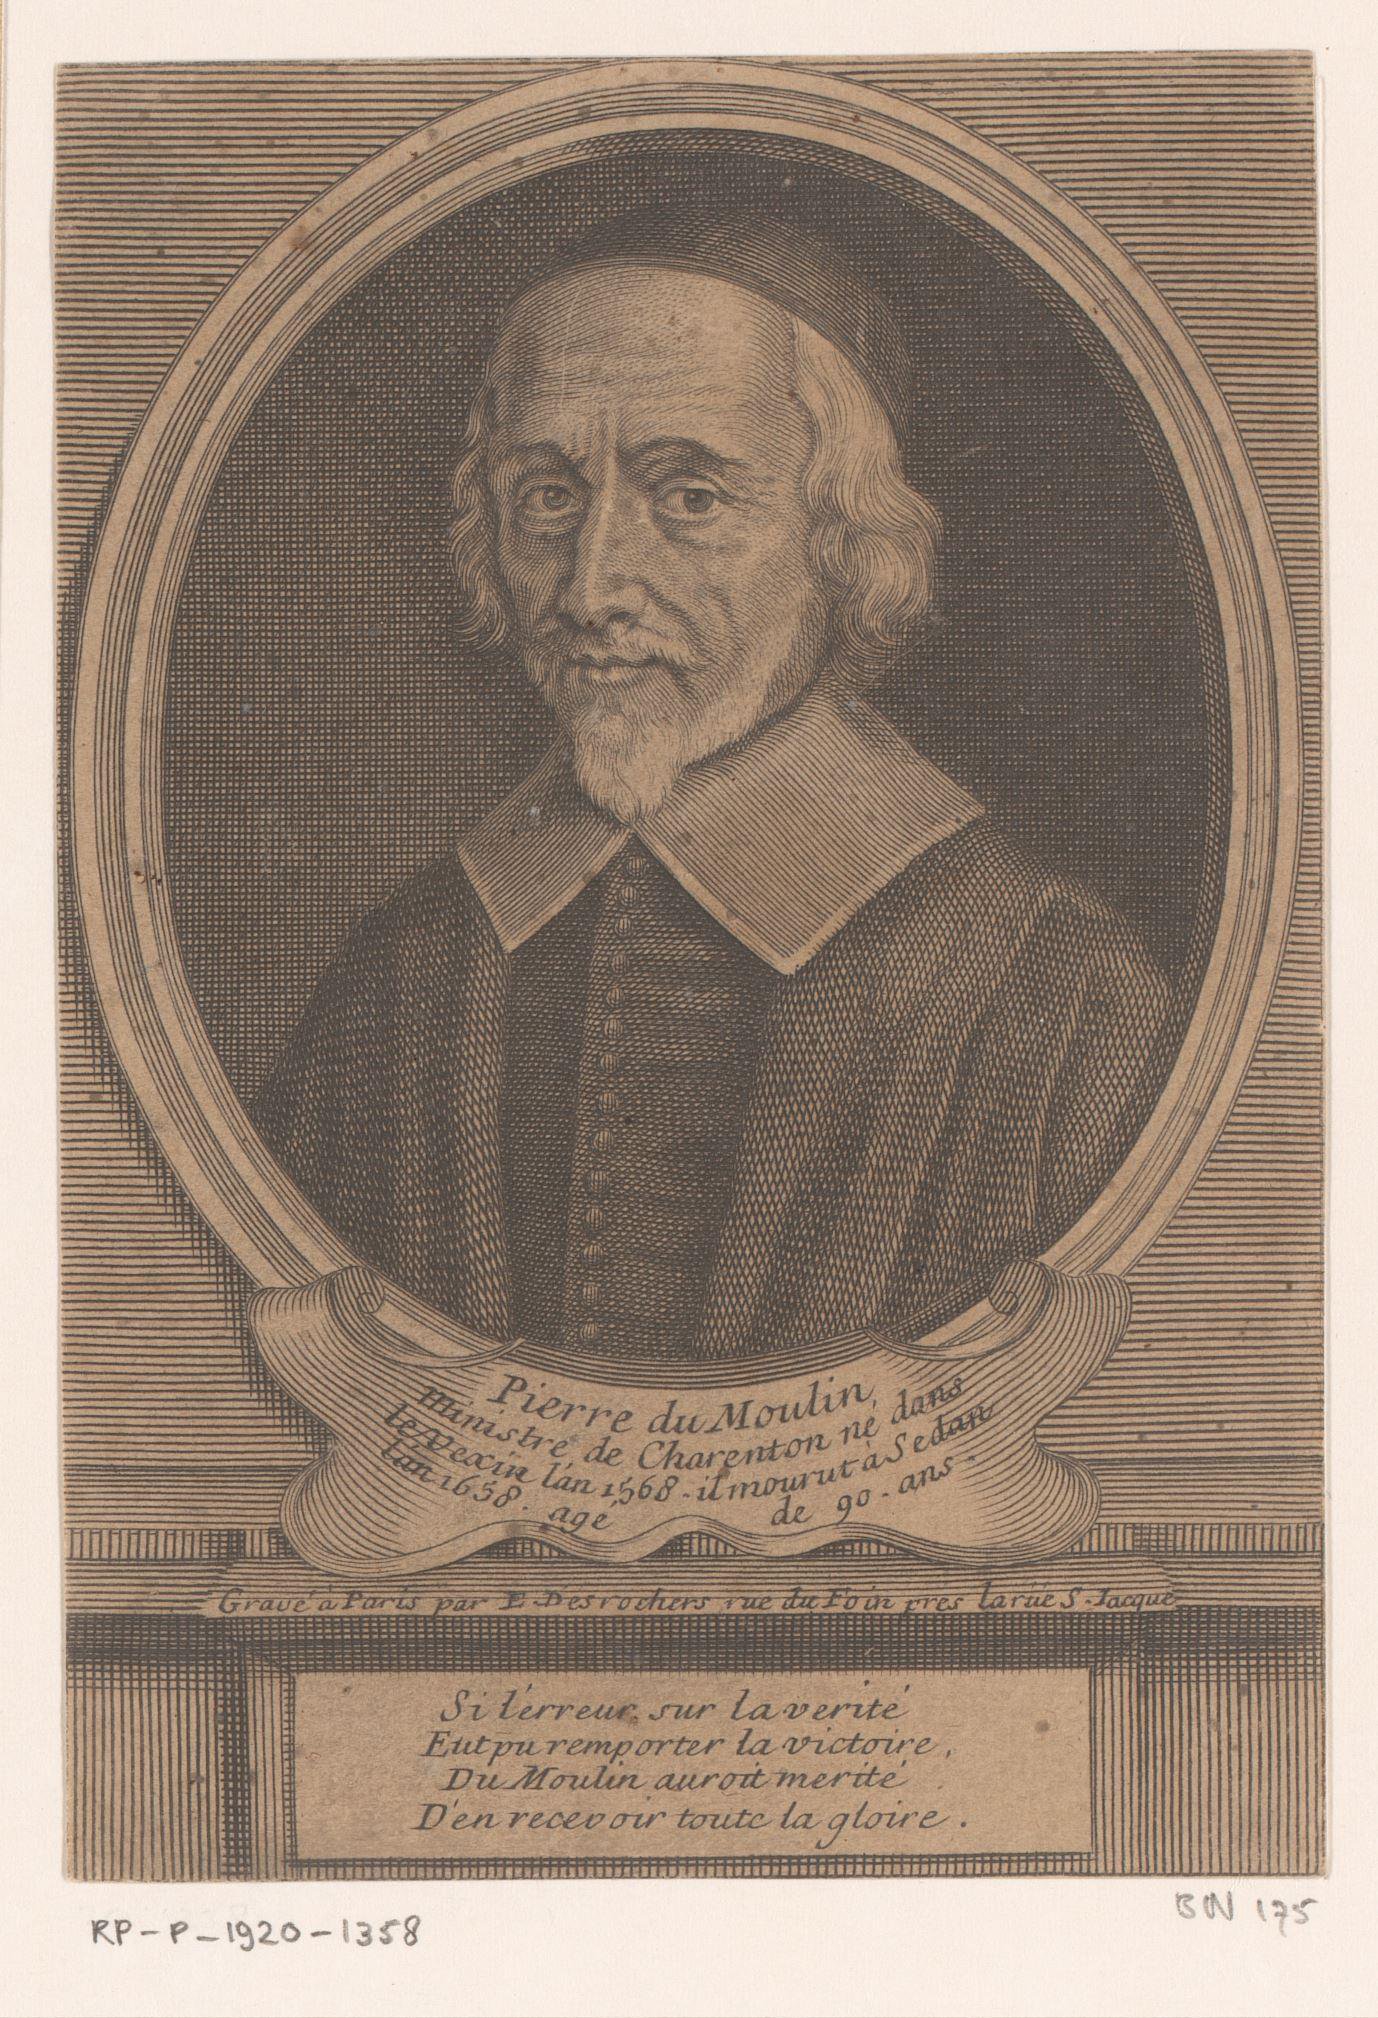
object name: print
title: Portret van Pierre du Moulin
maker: étienne desrochers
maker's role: print maker, publisher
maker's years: 1668-1741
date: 1726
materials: paper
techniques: engraving, etching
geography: paris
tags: minister ~ government, historical persons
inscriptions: collector's mark: Lugt 2228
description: Behoort waarschijnlijk tot een serie portretten, grotendeels door Etienne Desrochers, getiteld: 'Recueil de portraits de personnes qui se sont distinguées tant dans les Armes que dans Belles-Lettres et les Arts, comme aussi la famille royale de France et autres cours étrangères'. De serie werd initieel uitgegeven door Desrochers en aangekondigd in 'Mercure' in mei 1726, p. 985. Echter was Desrochers reeds enkele jaren eerder begonnen met het uitgeven van de serie. Na de dood van Desrochers werd de serie voortgezet door Gilles Edme Petit. Een latere staat werd uitgegeven door Jean François Daumont in Parijs.